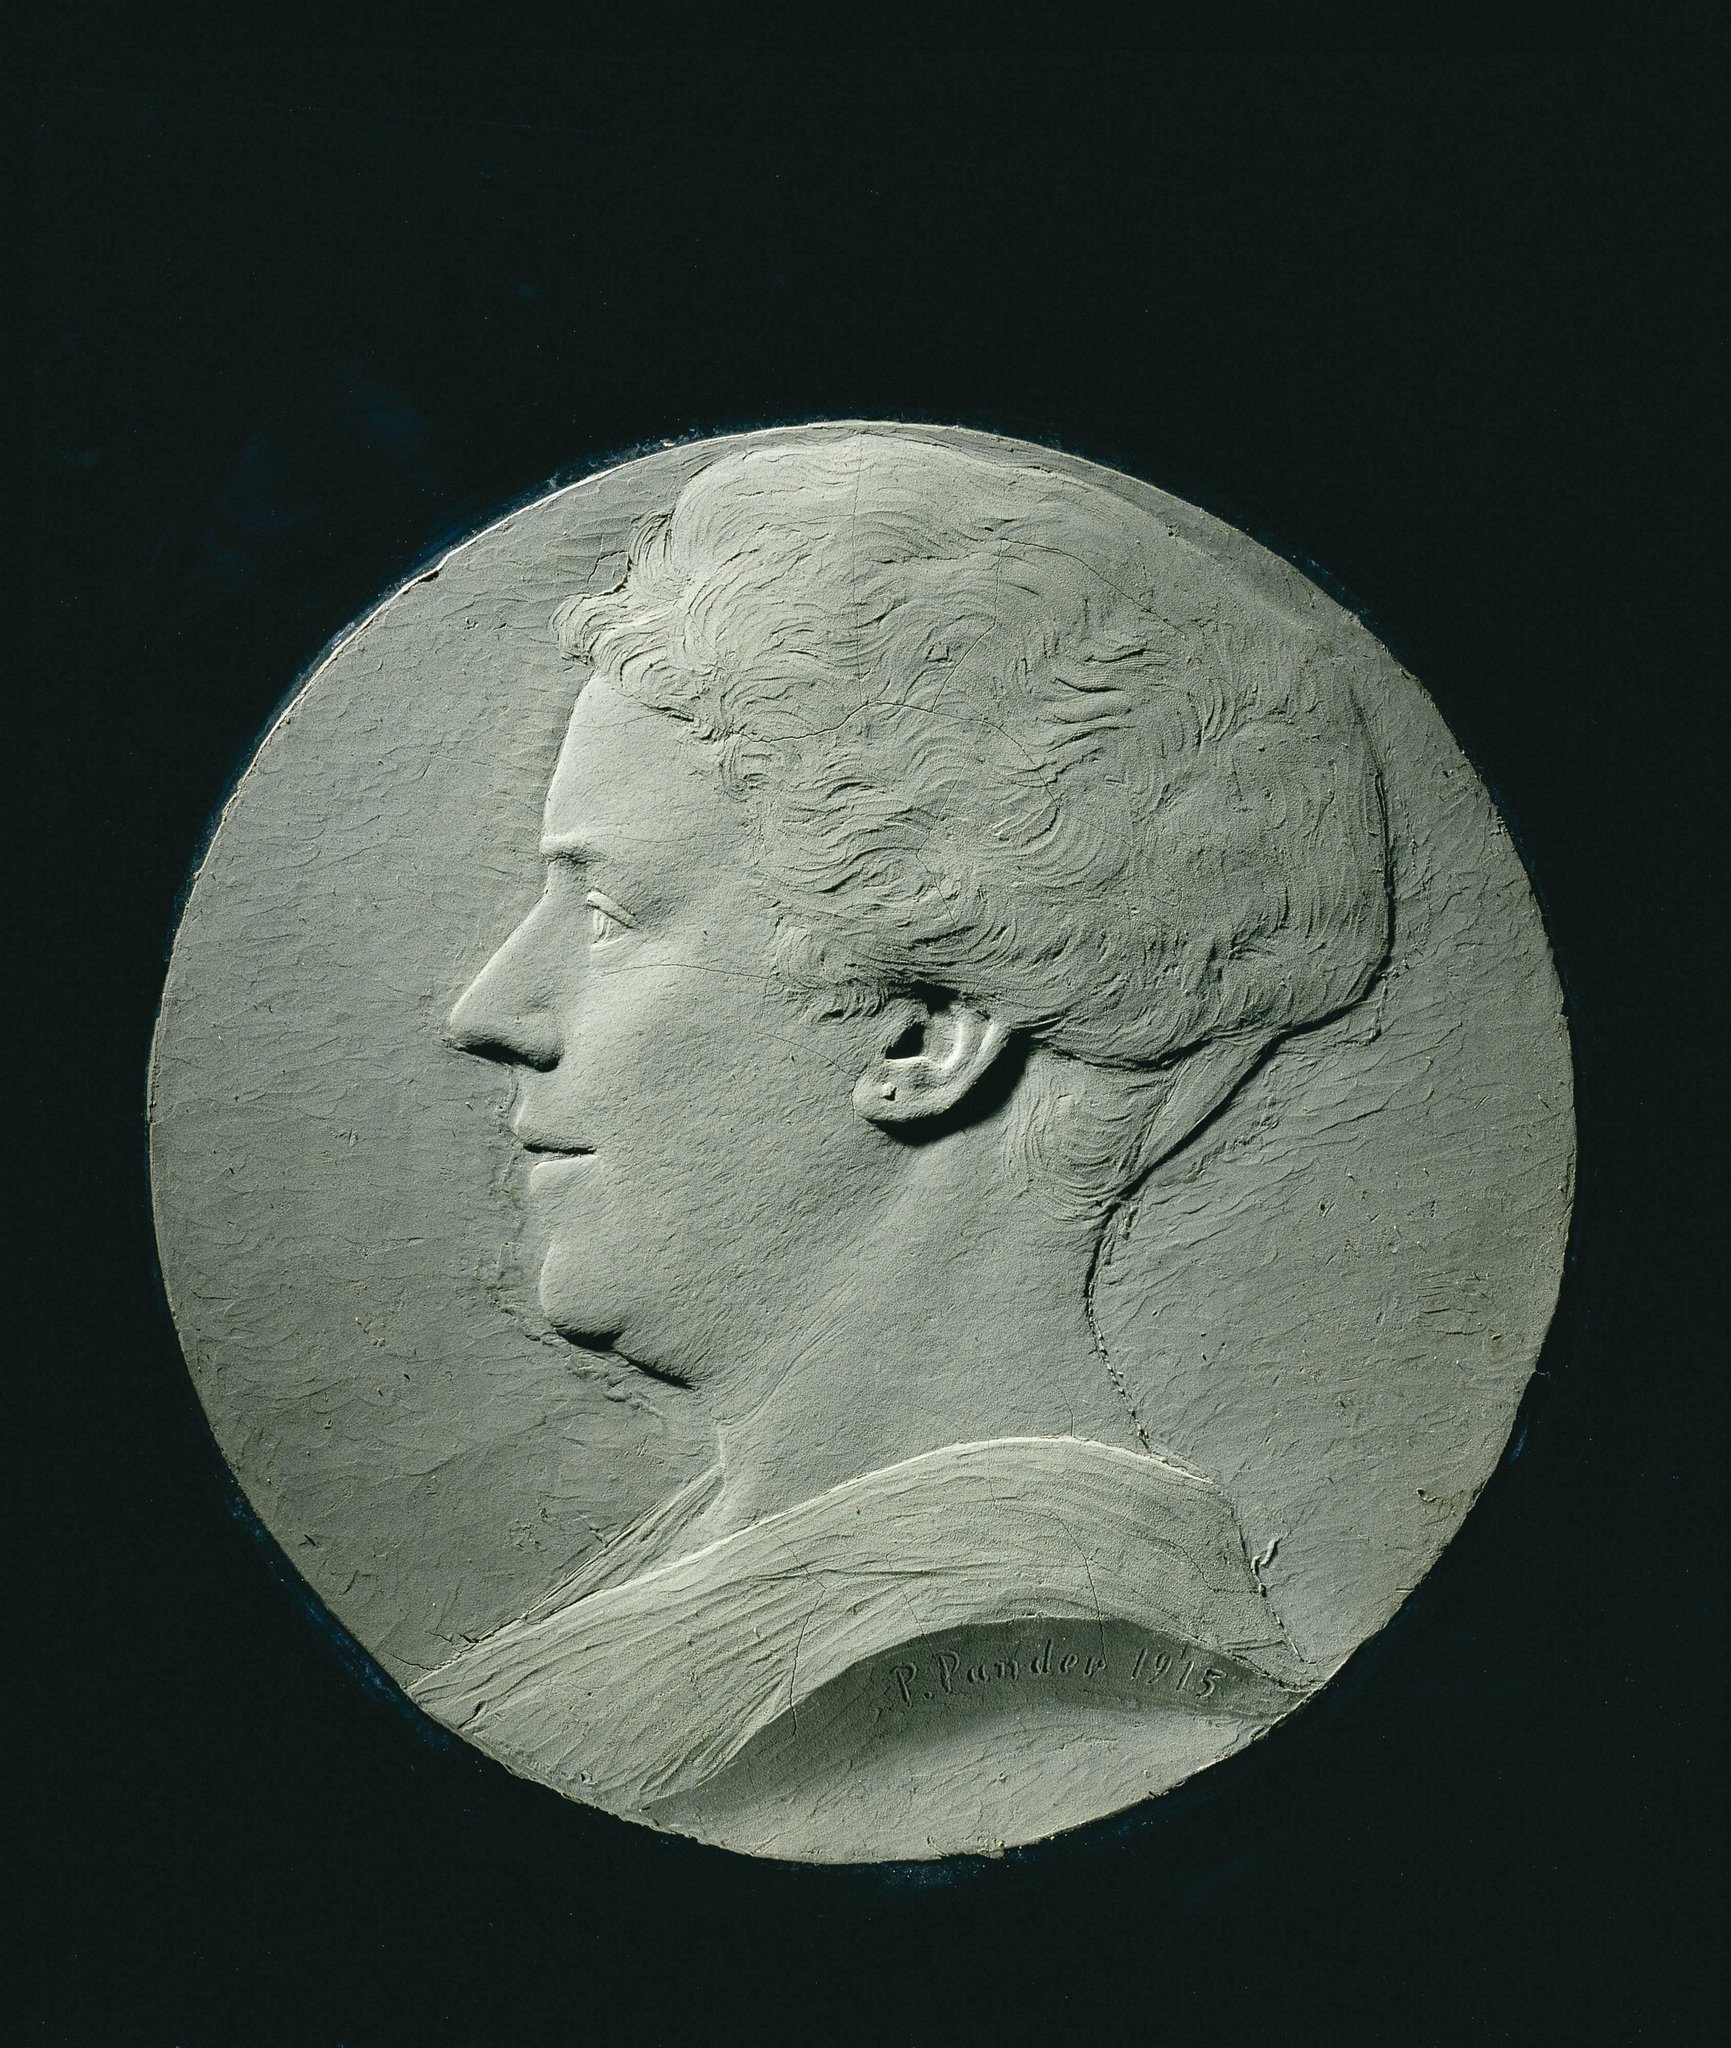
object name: sculpture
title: Mathilde Mengelberg-Wübbe (1875-1943)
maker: pier pander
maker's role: designer, draughtsman, sculptor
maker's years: 1864-1919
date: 1915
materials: glass, wood, plastic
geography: amsterdam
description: Medaillonportret van Mathilde Mengelberg-Wübbe. Het beeld is gesigneerd: P. Pander en gedateerd: 1915. Het is een plasticine-uitvoering die als moeder-vorm gebruikt werd, waarvan latere exemplaren in oa. gips gemaakt werden. Het portret vormt de tegenhanger van het portret van Willem Mengelberg, waarvan het Rijksmuseum een gipsen versie bezit (BK-1970-25) en het Haags Gemeentemuseum een marmeren. De groene plasticine ligt op een glasplaat in de oorspronkelijke, eikenhouten lijst.